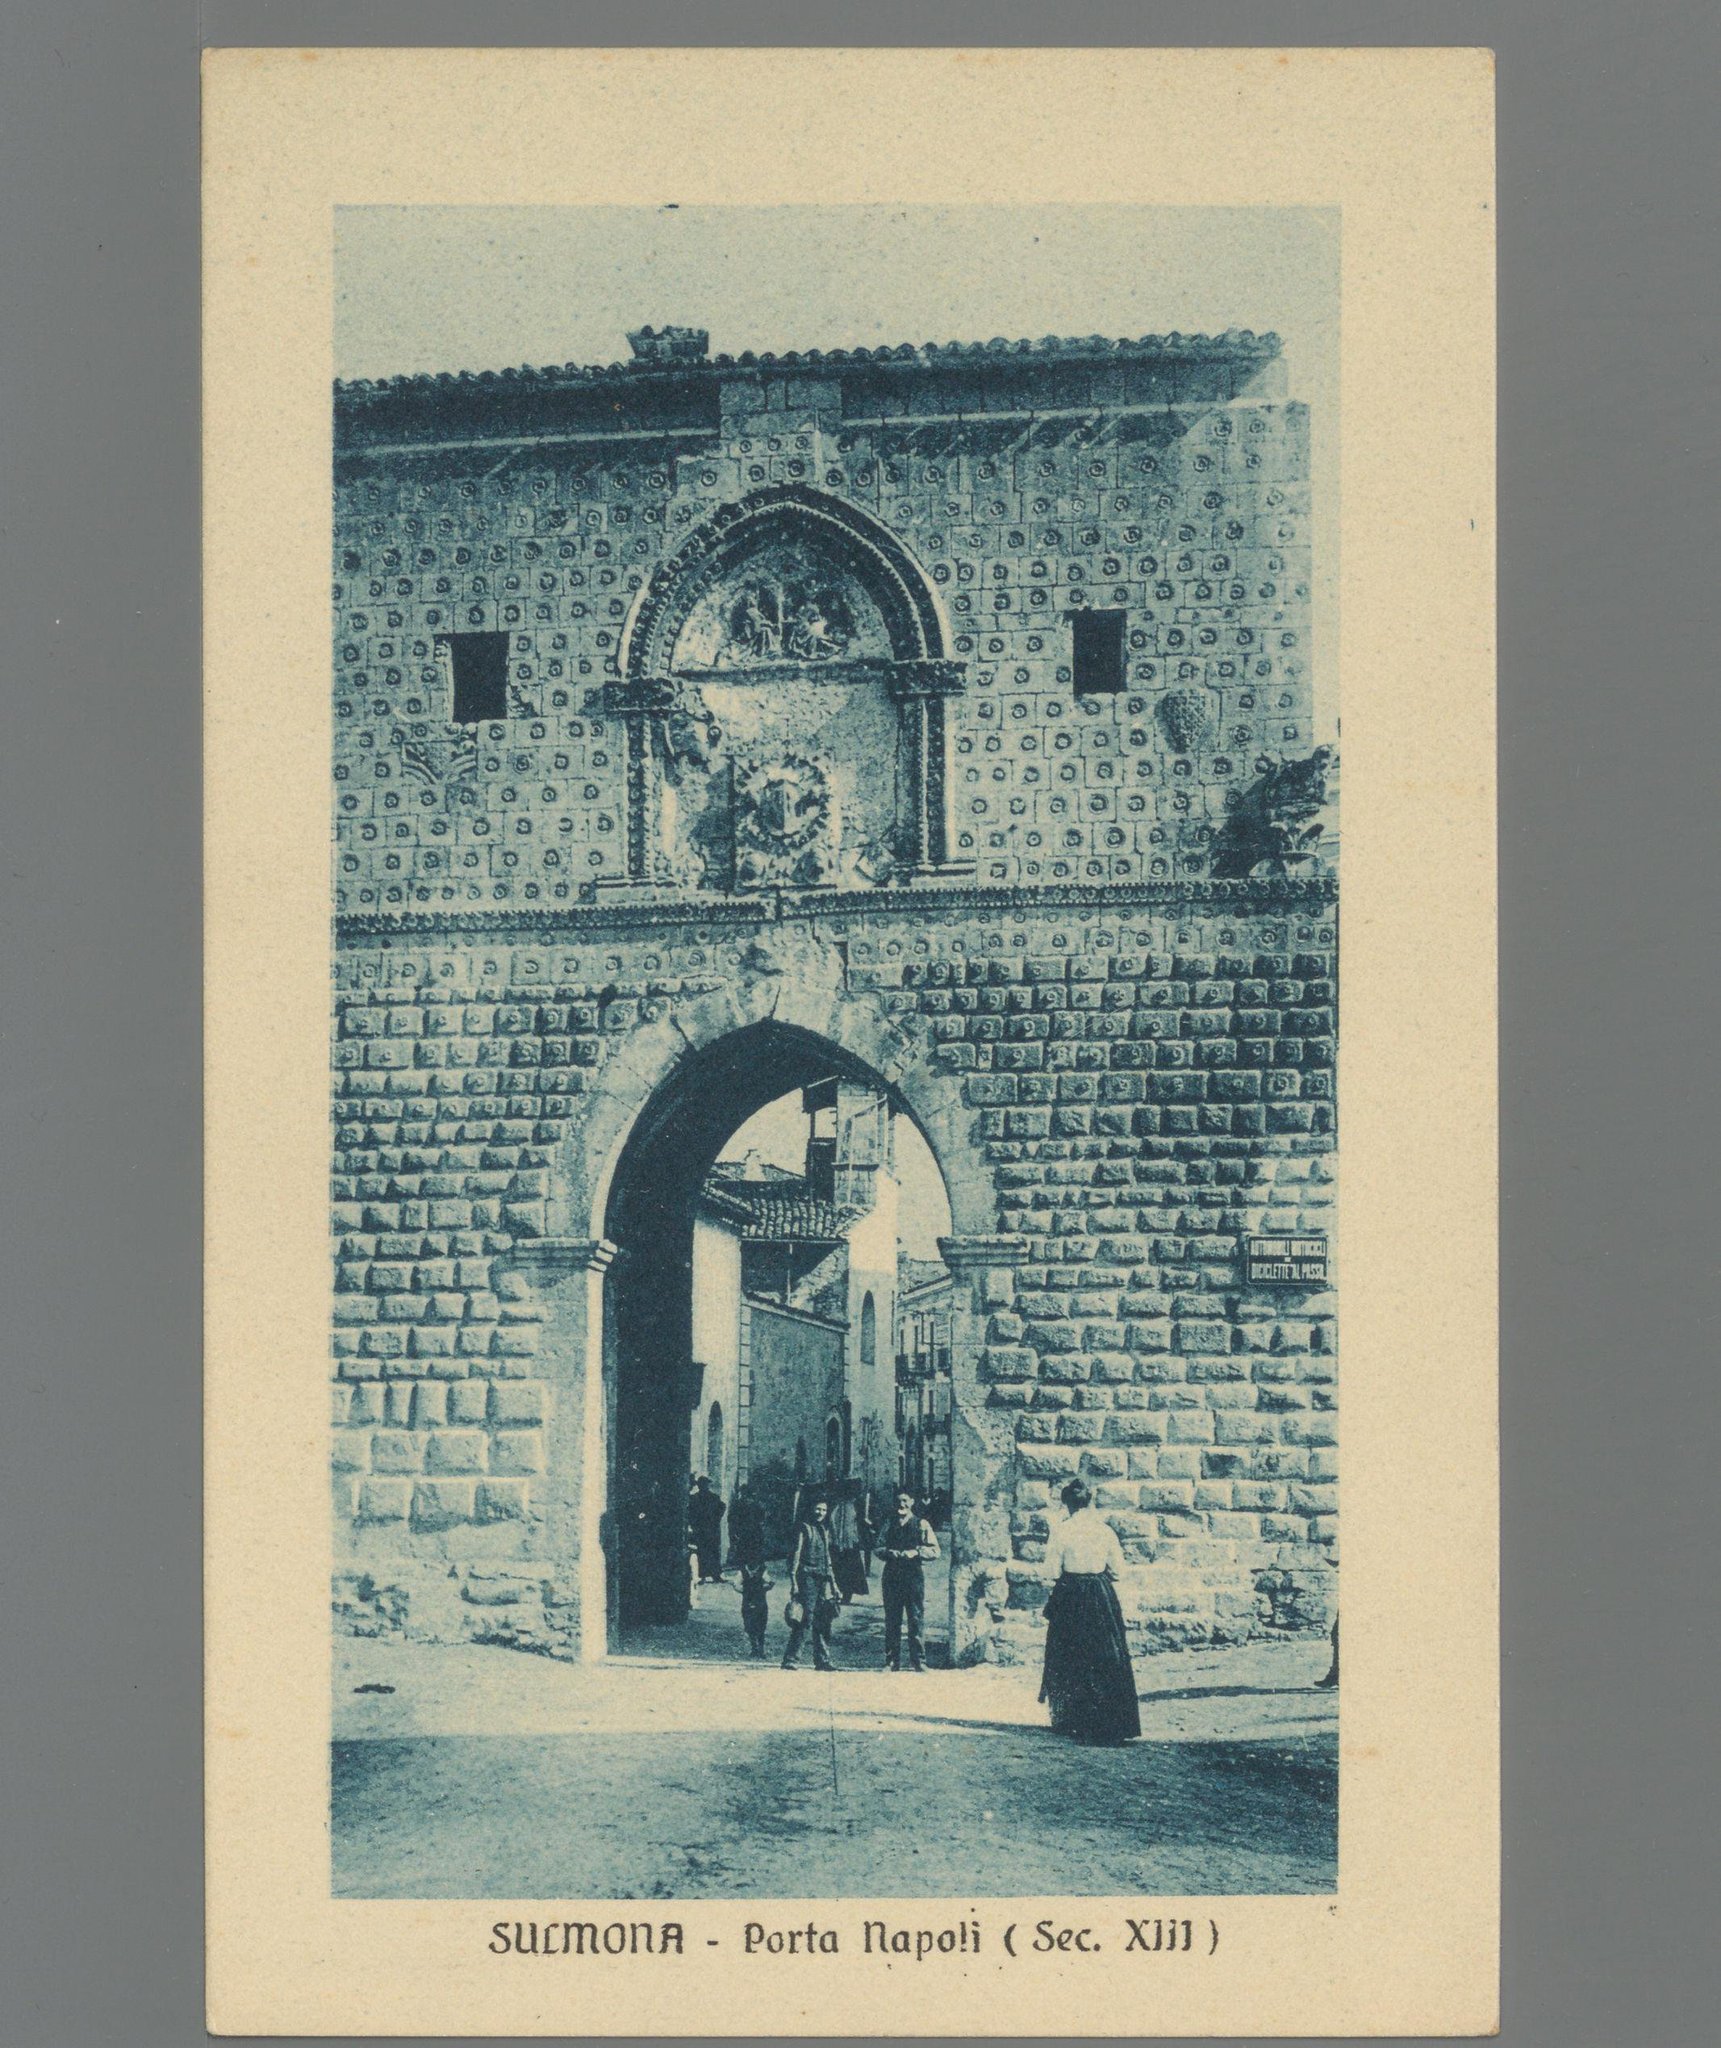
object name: ansichtkaart, prentbriefkaart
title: Sulmona. Porta Napoli (Sec. XIII)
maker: Anonymous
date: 1906-1920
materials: cardboard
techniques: photograph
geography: sulmona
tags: city-view, and landscape with man-made constructions (+ city(-scape) with figures, staffage), city-gate (+ city(-scape) with figures, staffage)